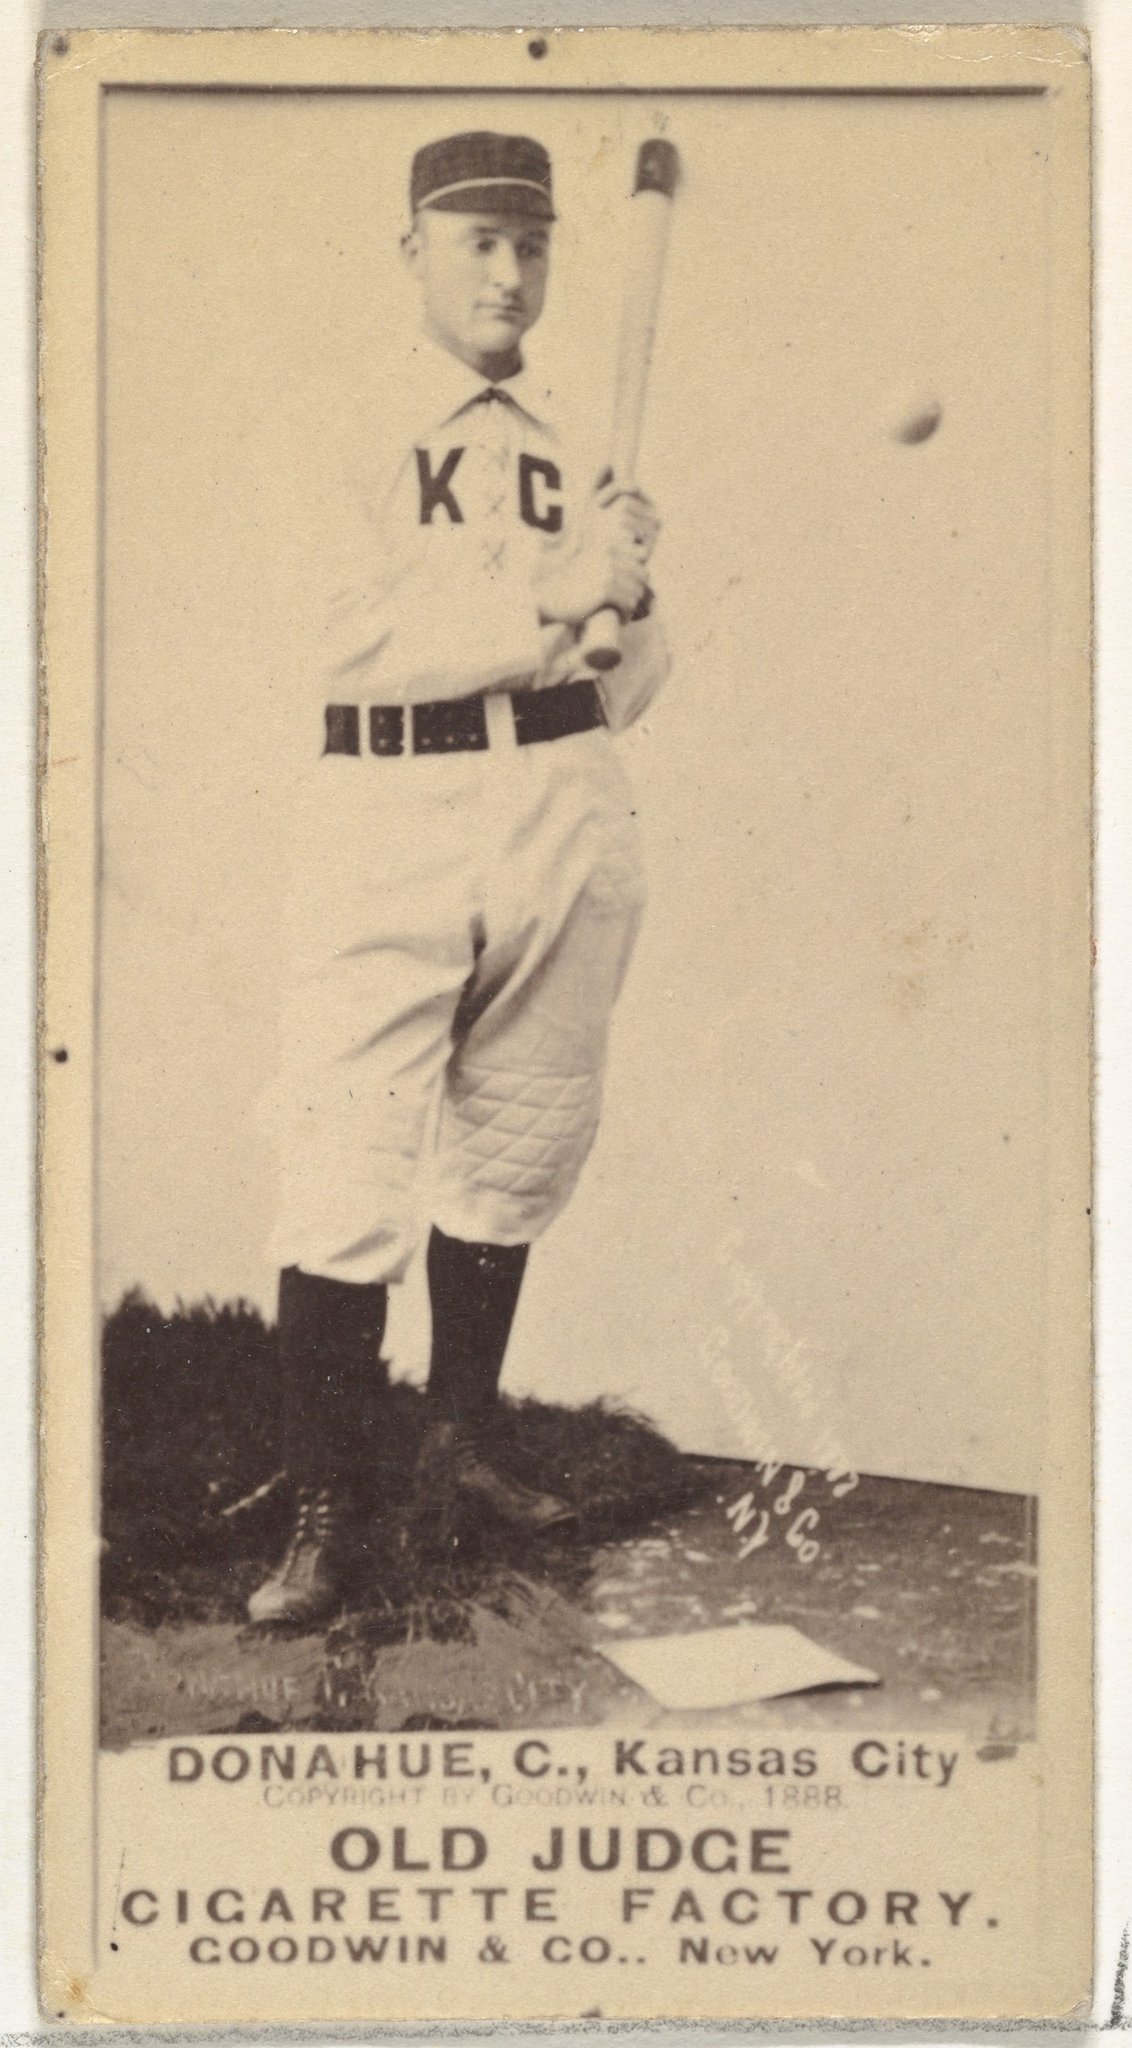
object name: baseball card, photograph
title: James Augustus "Jim" Donahue, Catcher, Kansas City Cowboys, from the Old Judge series (N172) for Old Judge Cigarettes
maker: goodwin & company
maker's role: publisher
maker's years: 1850-1950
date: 1888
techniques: albumen silver print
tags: men,portraits,baseball,athletes